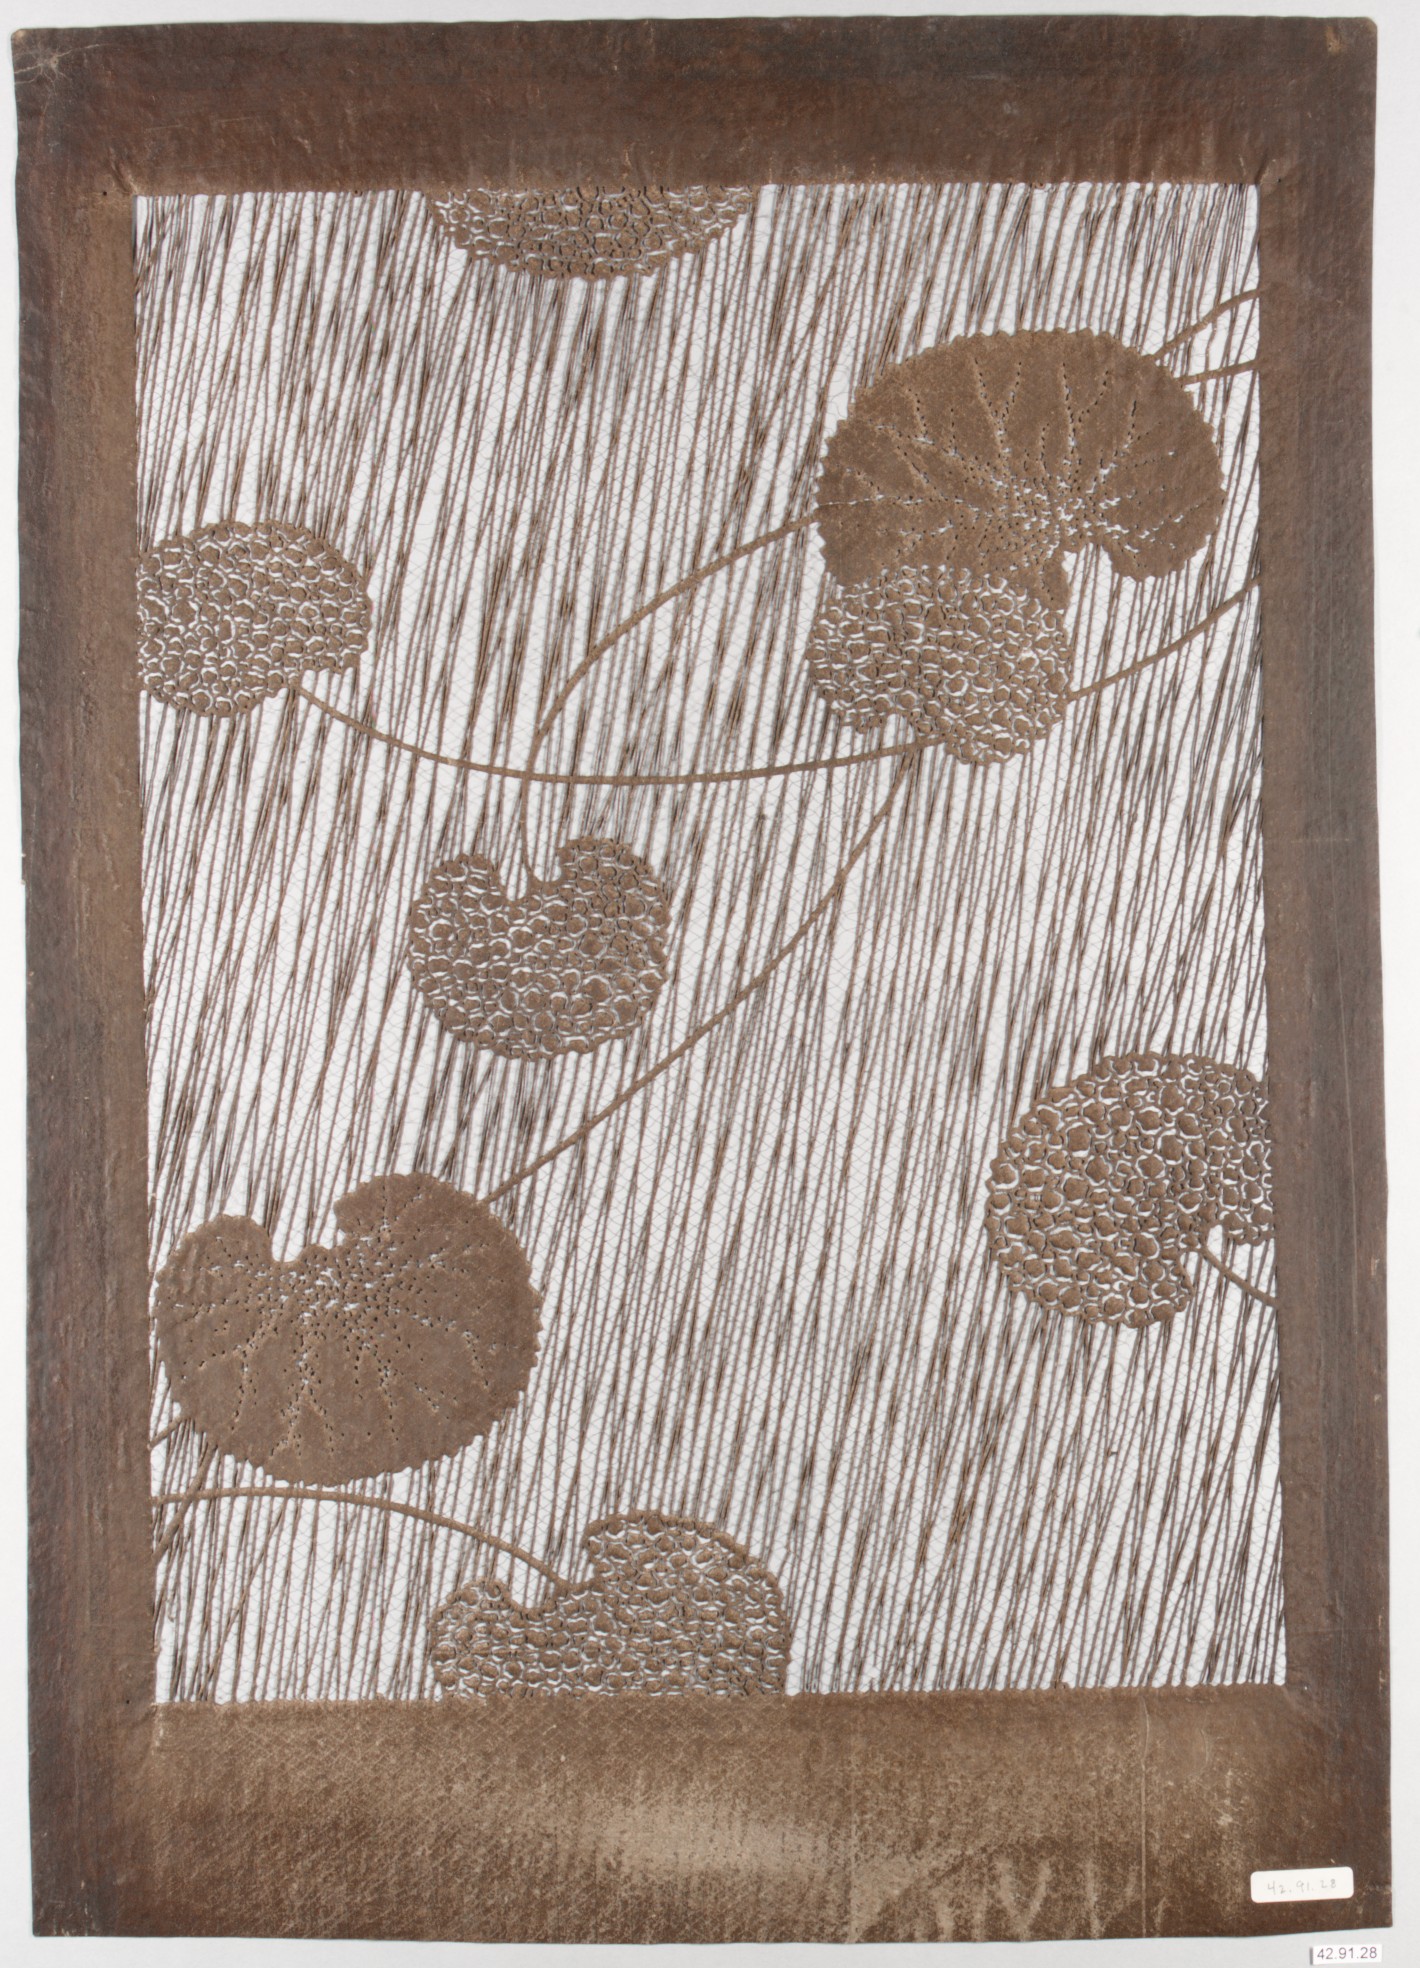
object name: stencil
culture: japanese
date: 1801-1900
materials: paper, silk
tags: leaves